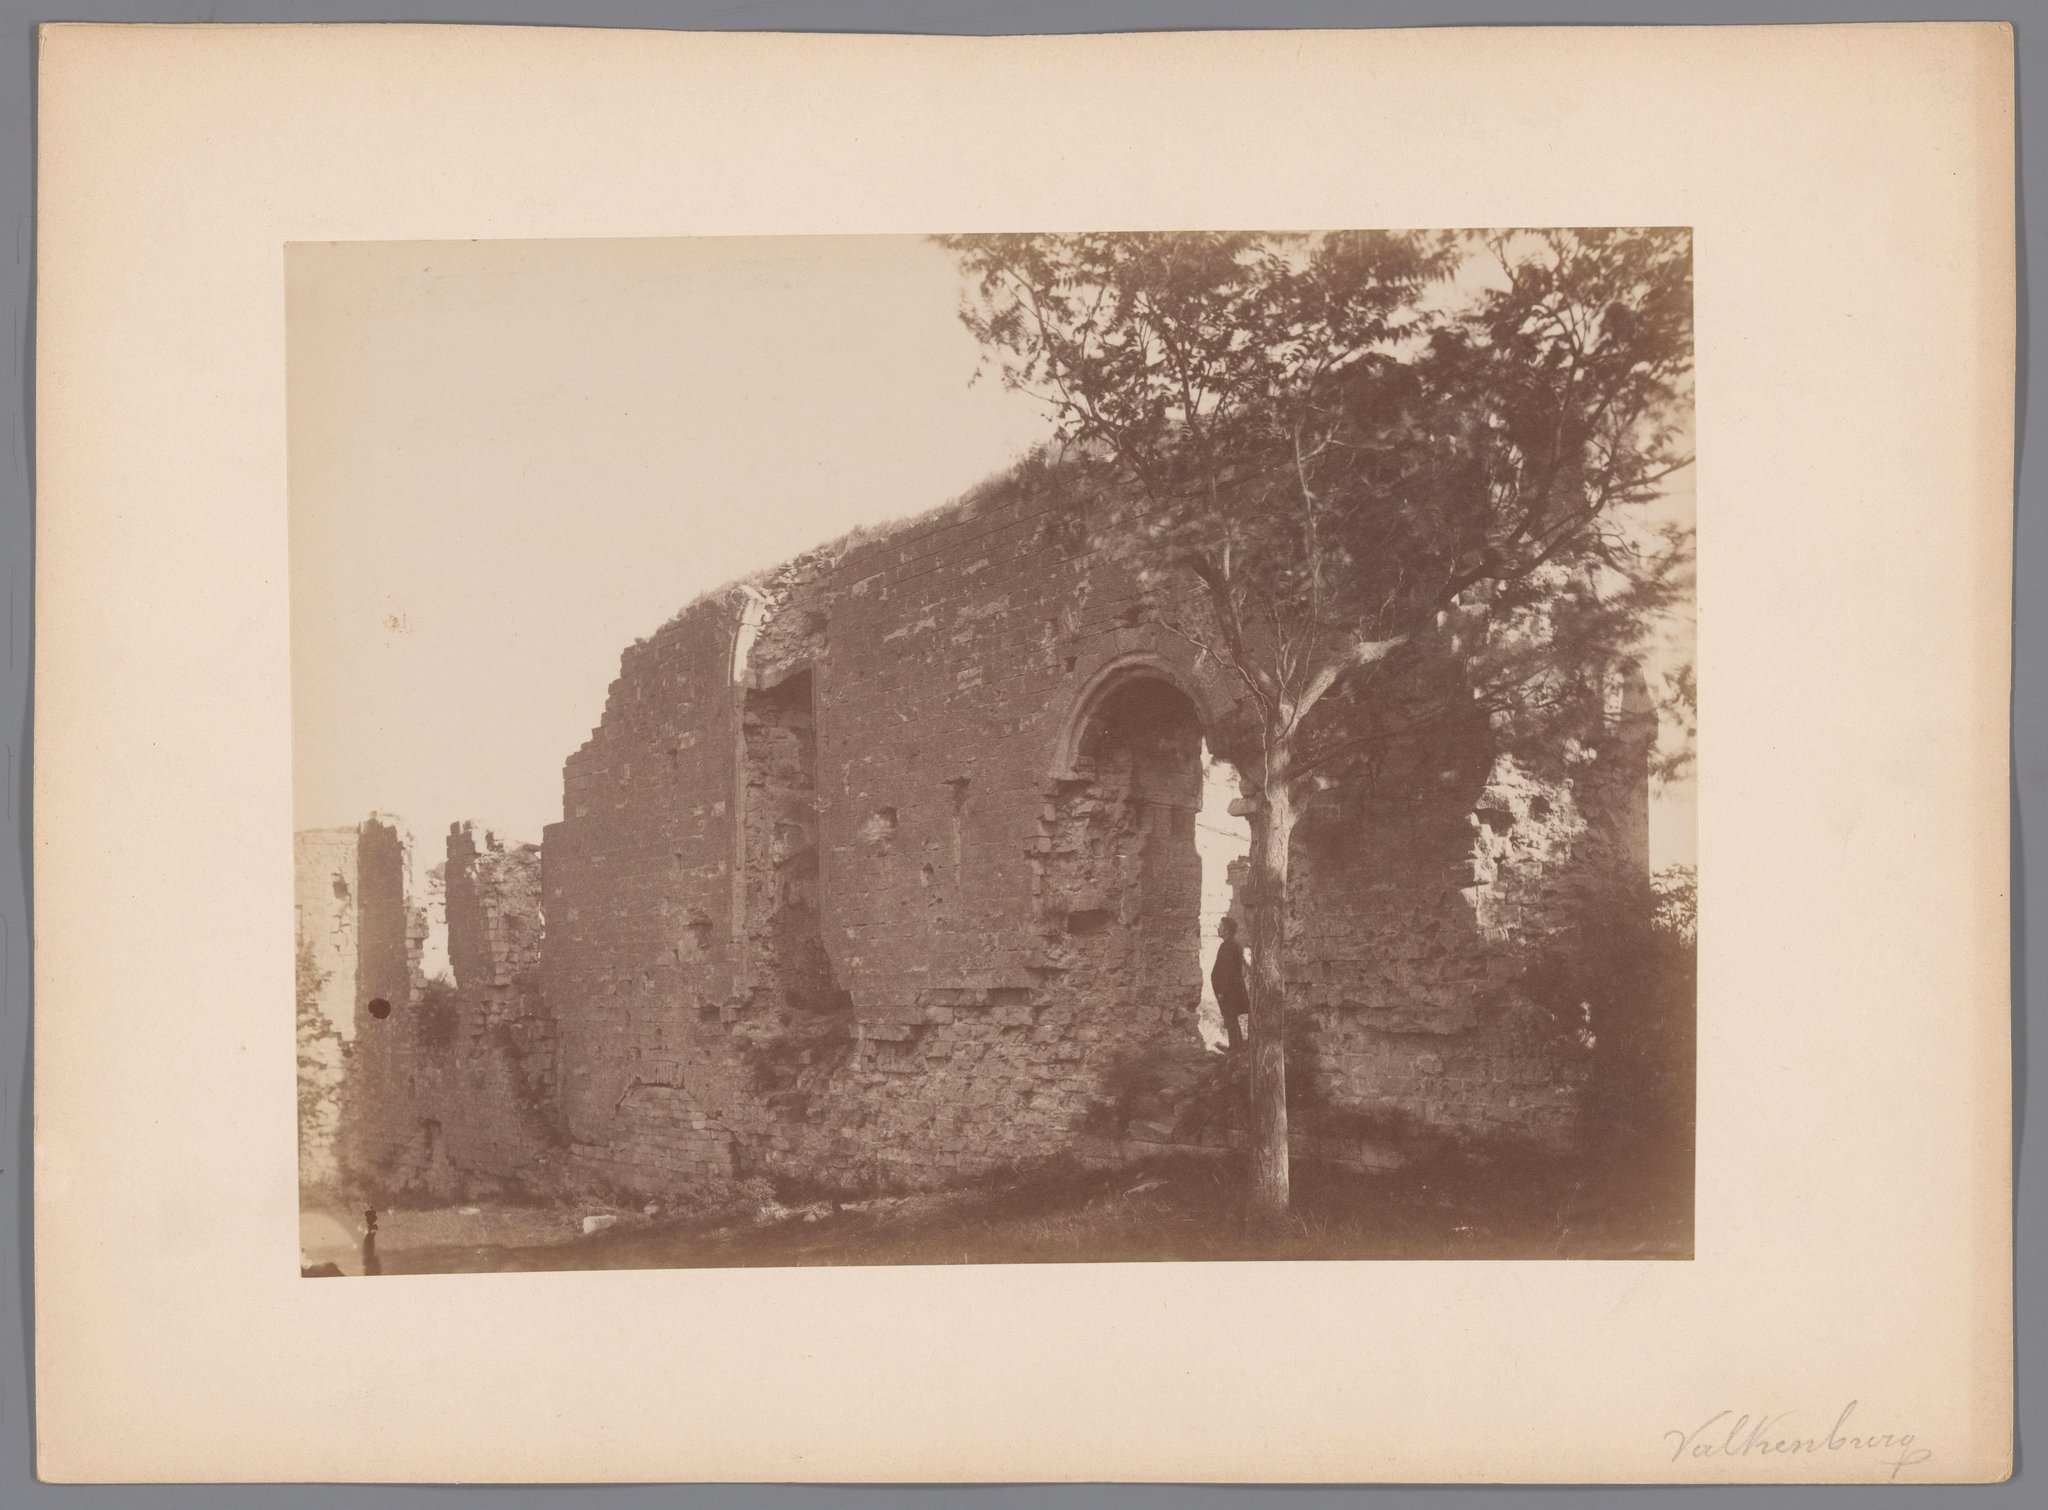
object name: photograph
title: Binnenplaats van de kasteelruïne te Valkenburg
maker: anoniem (monumentenzorg)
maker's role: fotograaf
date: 1890-1920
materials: cardboard, photographic support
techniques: albumen print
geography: valkenburg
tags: courtyard, ruin of a dwelling, house, castle, etc.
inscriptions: annotation: ‘Valkenburg’, annotation: ‘Ruïne te Valkenburg/ aanzicht v/d binnenplaats’